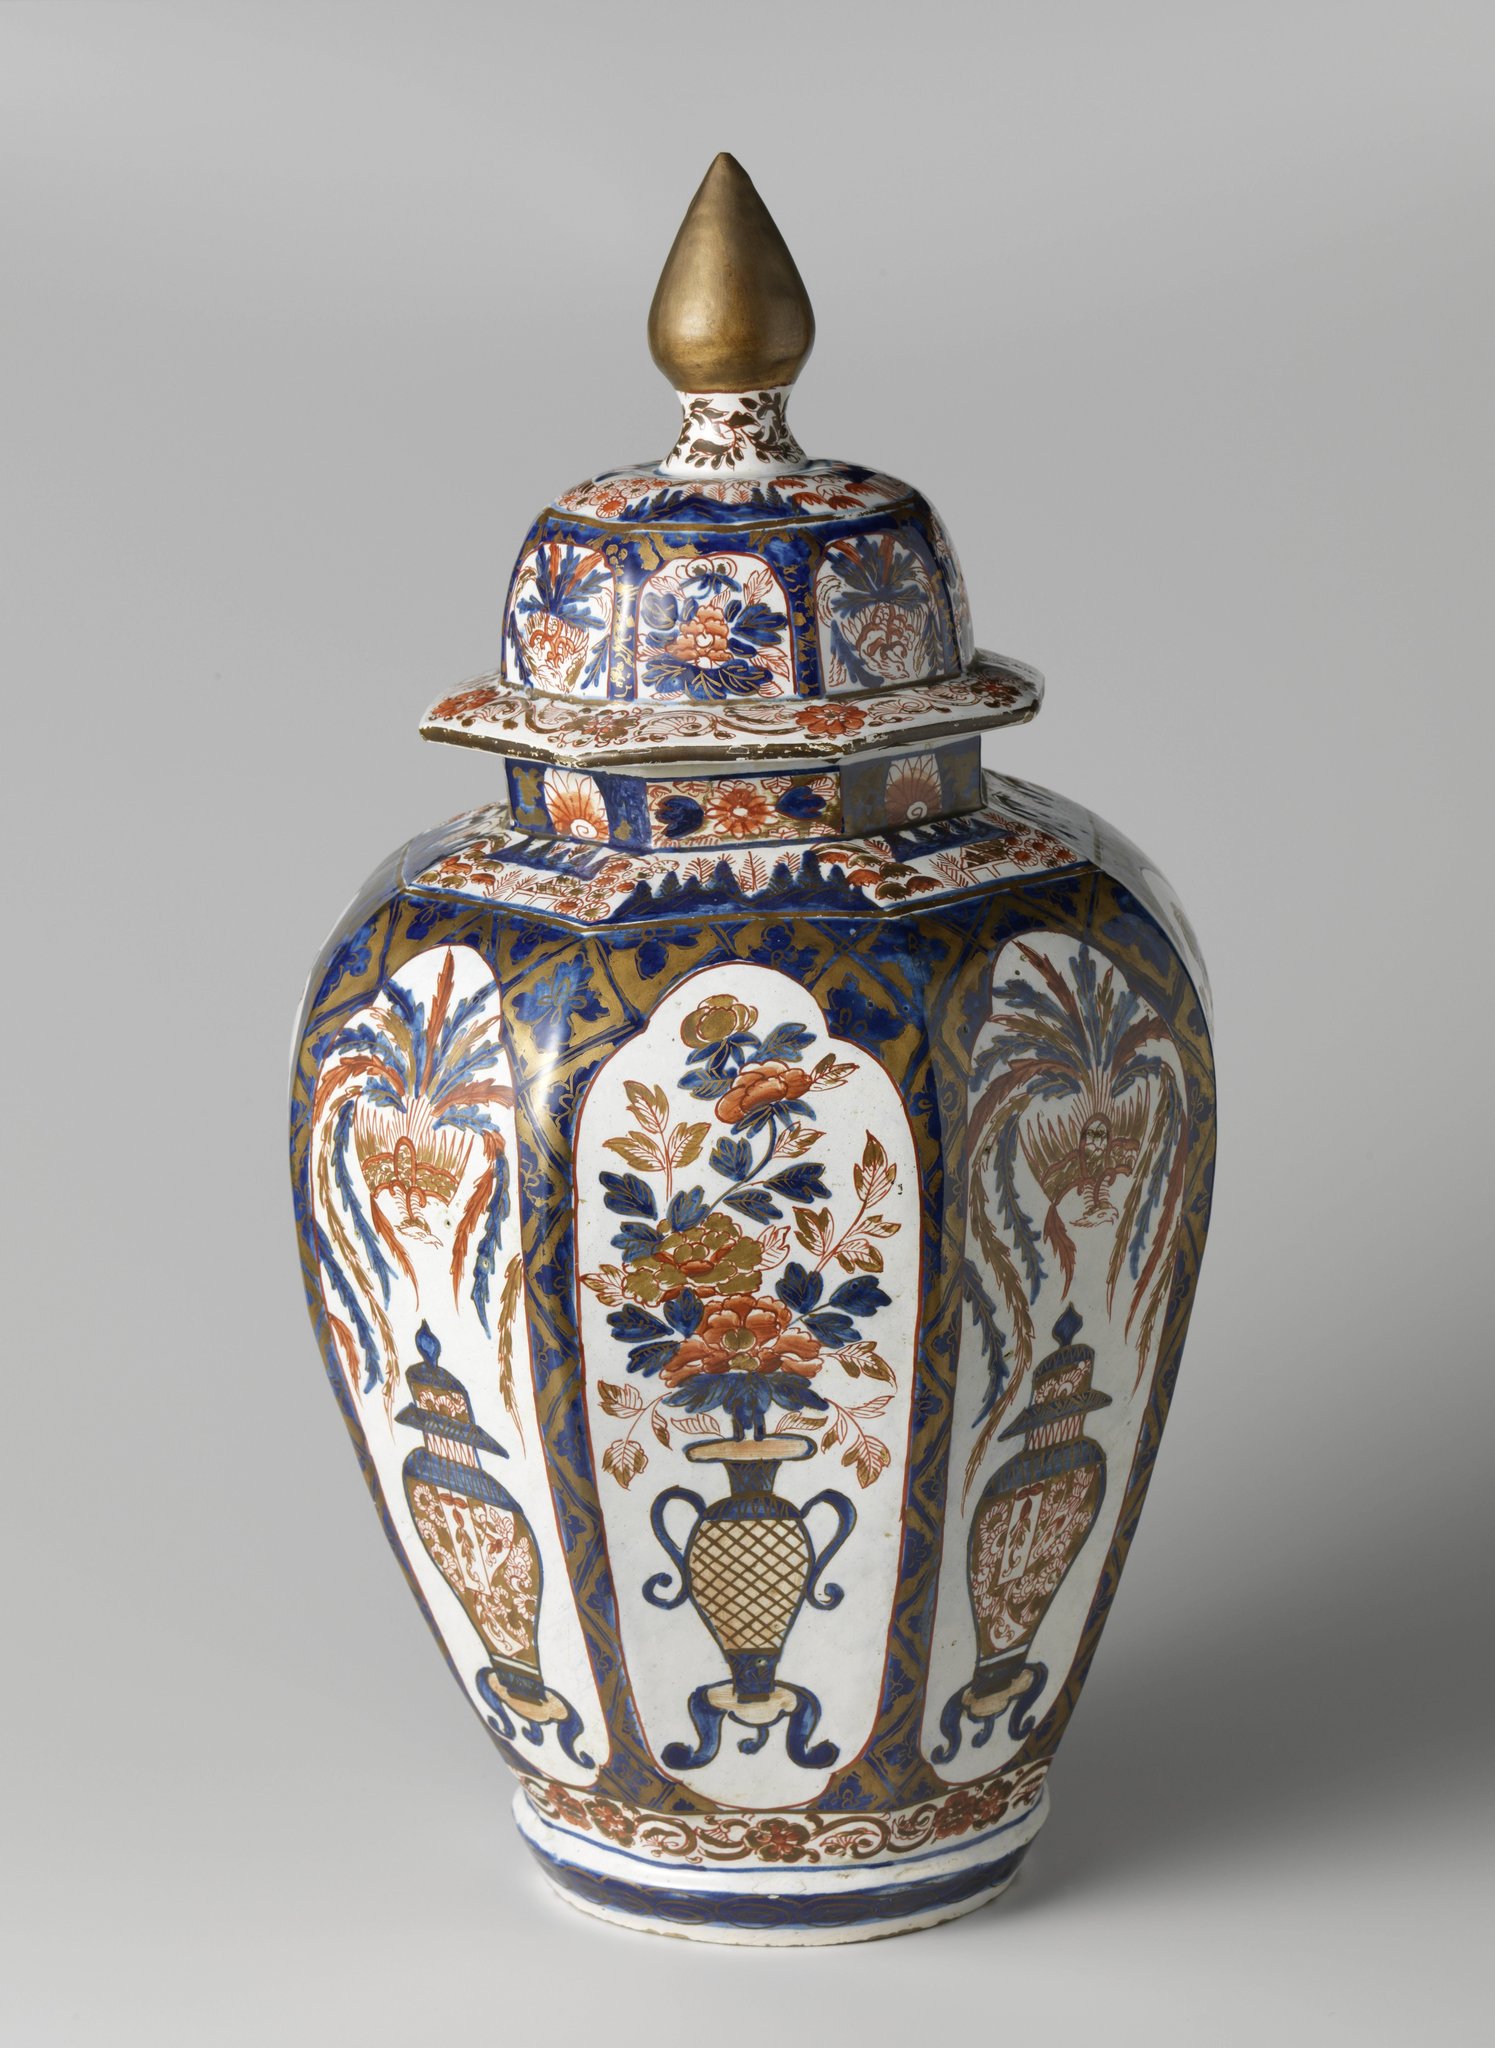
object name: lid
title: Deksel van een pot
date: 1820-1850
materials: earthenware, glaze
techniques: painted, polychromy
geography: delft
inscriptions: mark: ‘IVP & C’, collector's mark: ‘collection J.F. Loudon’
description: Deksel van van veelkleurig beschilderde faïence. De pot is achtkantig en op de acht kanten zijn acht vakken geschilderd. In vier vakken is een vaas met twee s-vormige handvatten, staand op een driepotig voetstuk en gevuld met bloemen geschilderd, in de andere vier vakken een pot met deksel op een driepotig voetstuk waarboven een feniks. De pot is onderdeel van een stel en is gemerkt.